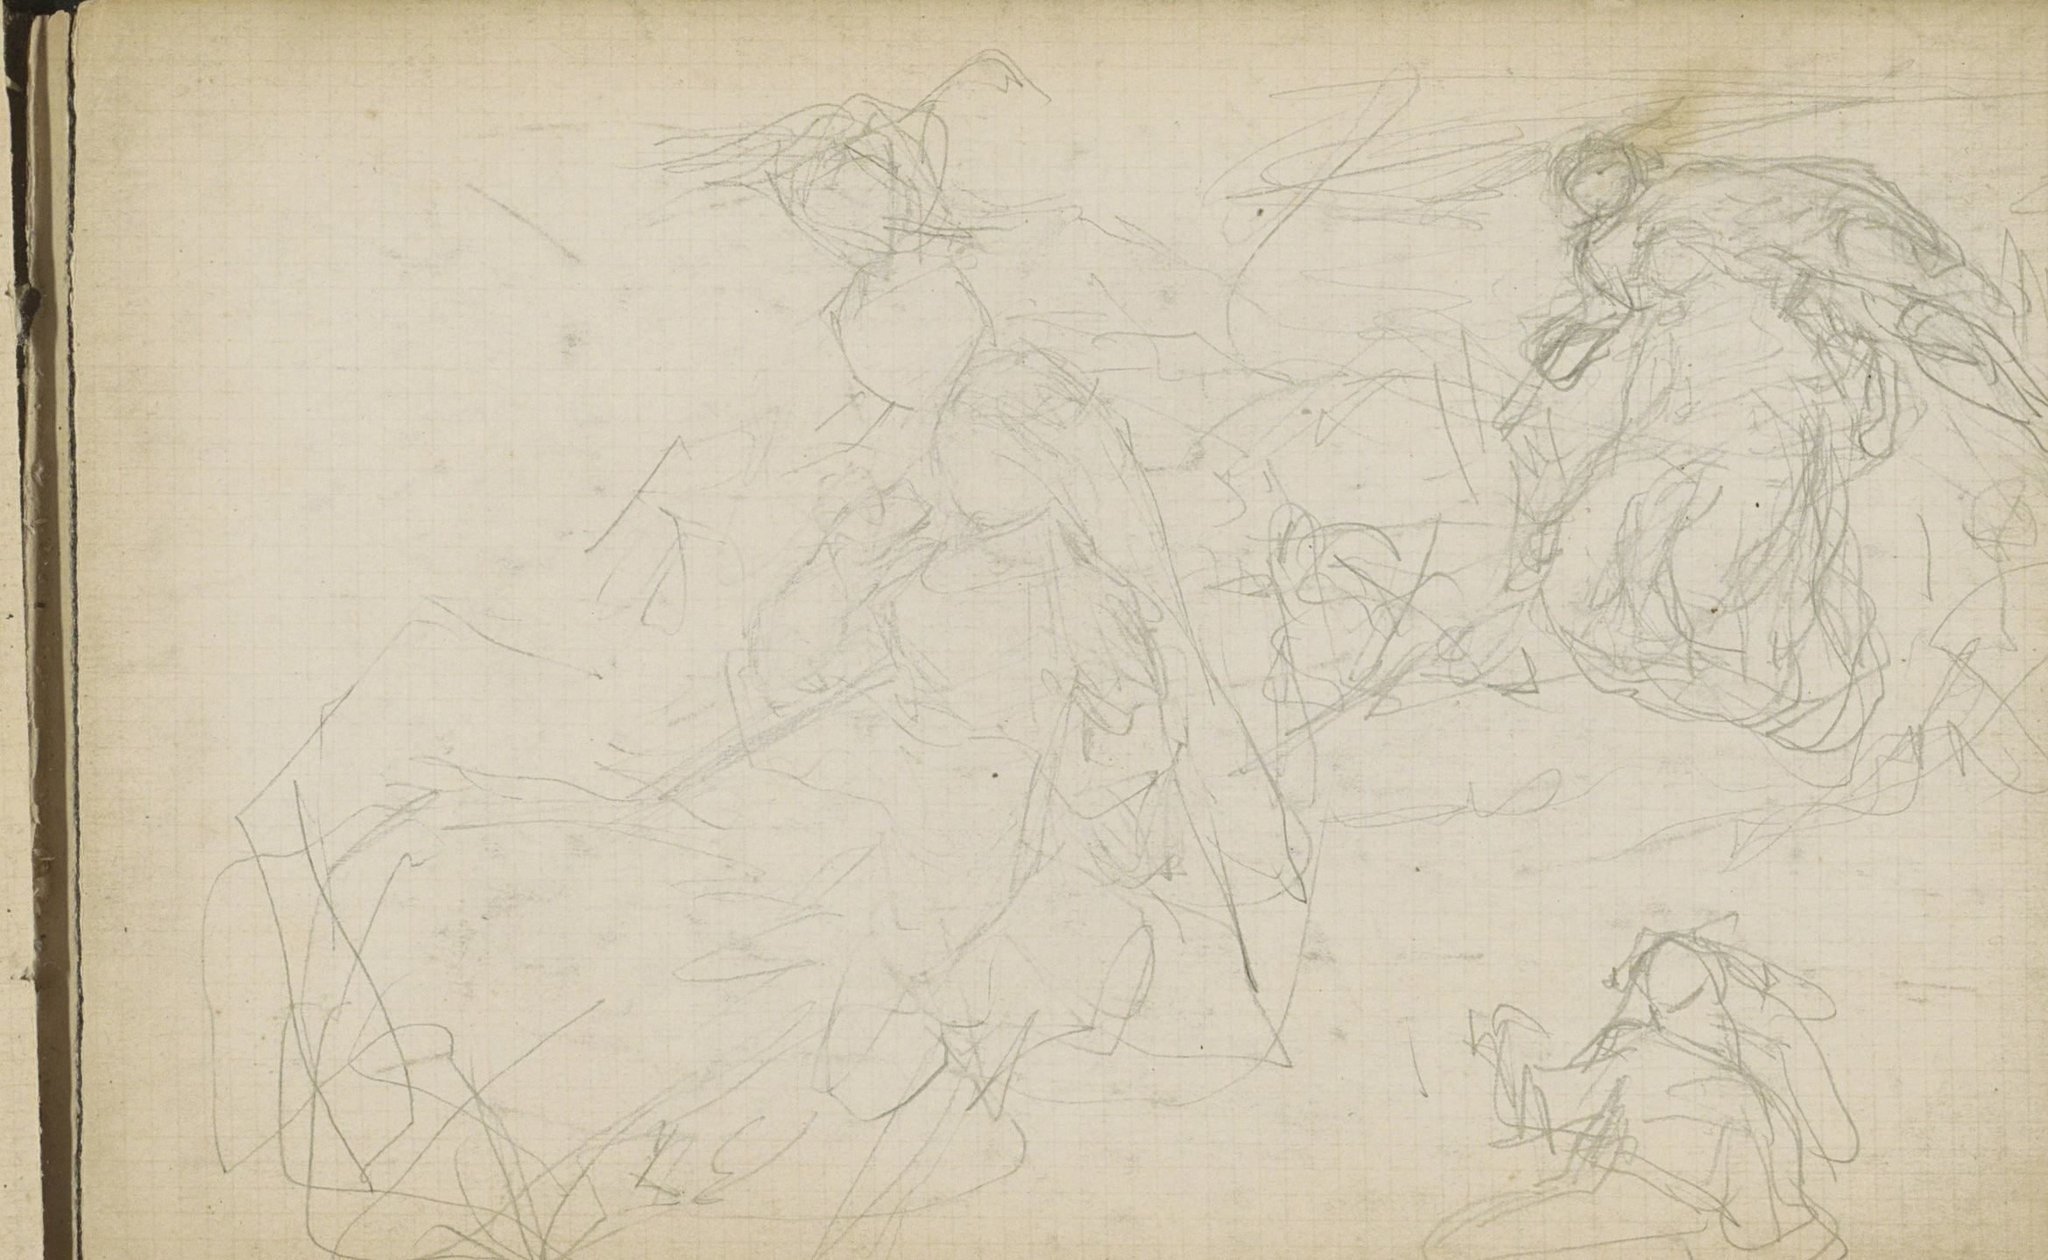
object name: sketchbook leaf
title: Studieblad, onder andere met een liggende vrouw en een liefdespaar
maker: matthijs maris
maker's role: draughtsman, painter, print maker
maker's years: 1839-1917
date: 1849-1917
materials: pencil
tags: lying figure (+ female (human being) (not to be used where -aa- is prescribed)), lovers' meeting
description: Achterste schutblad uit een schetsboek met 35 bladen.